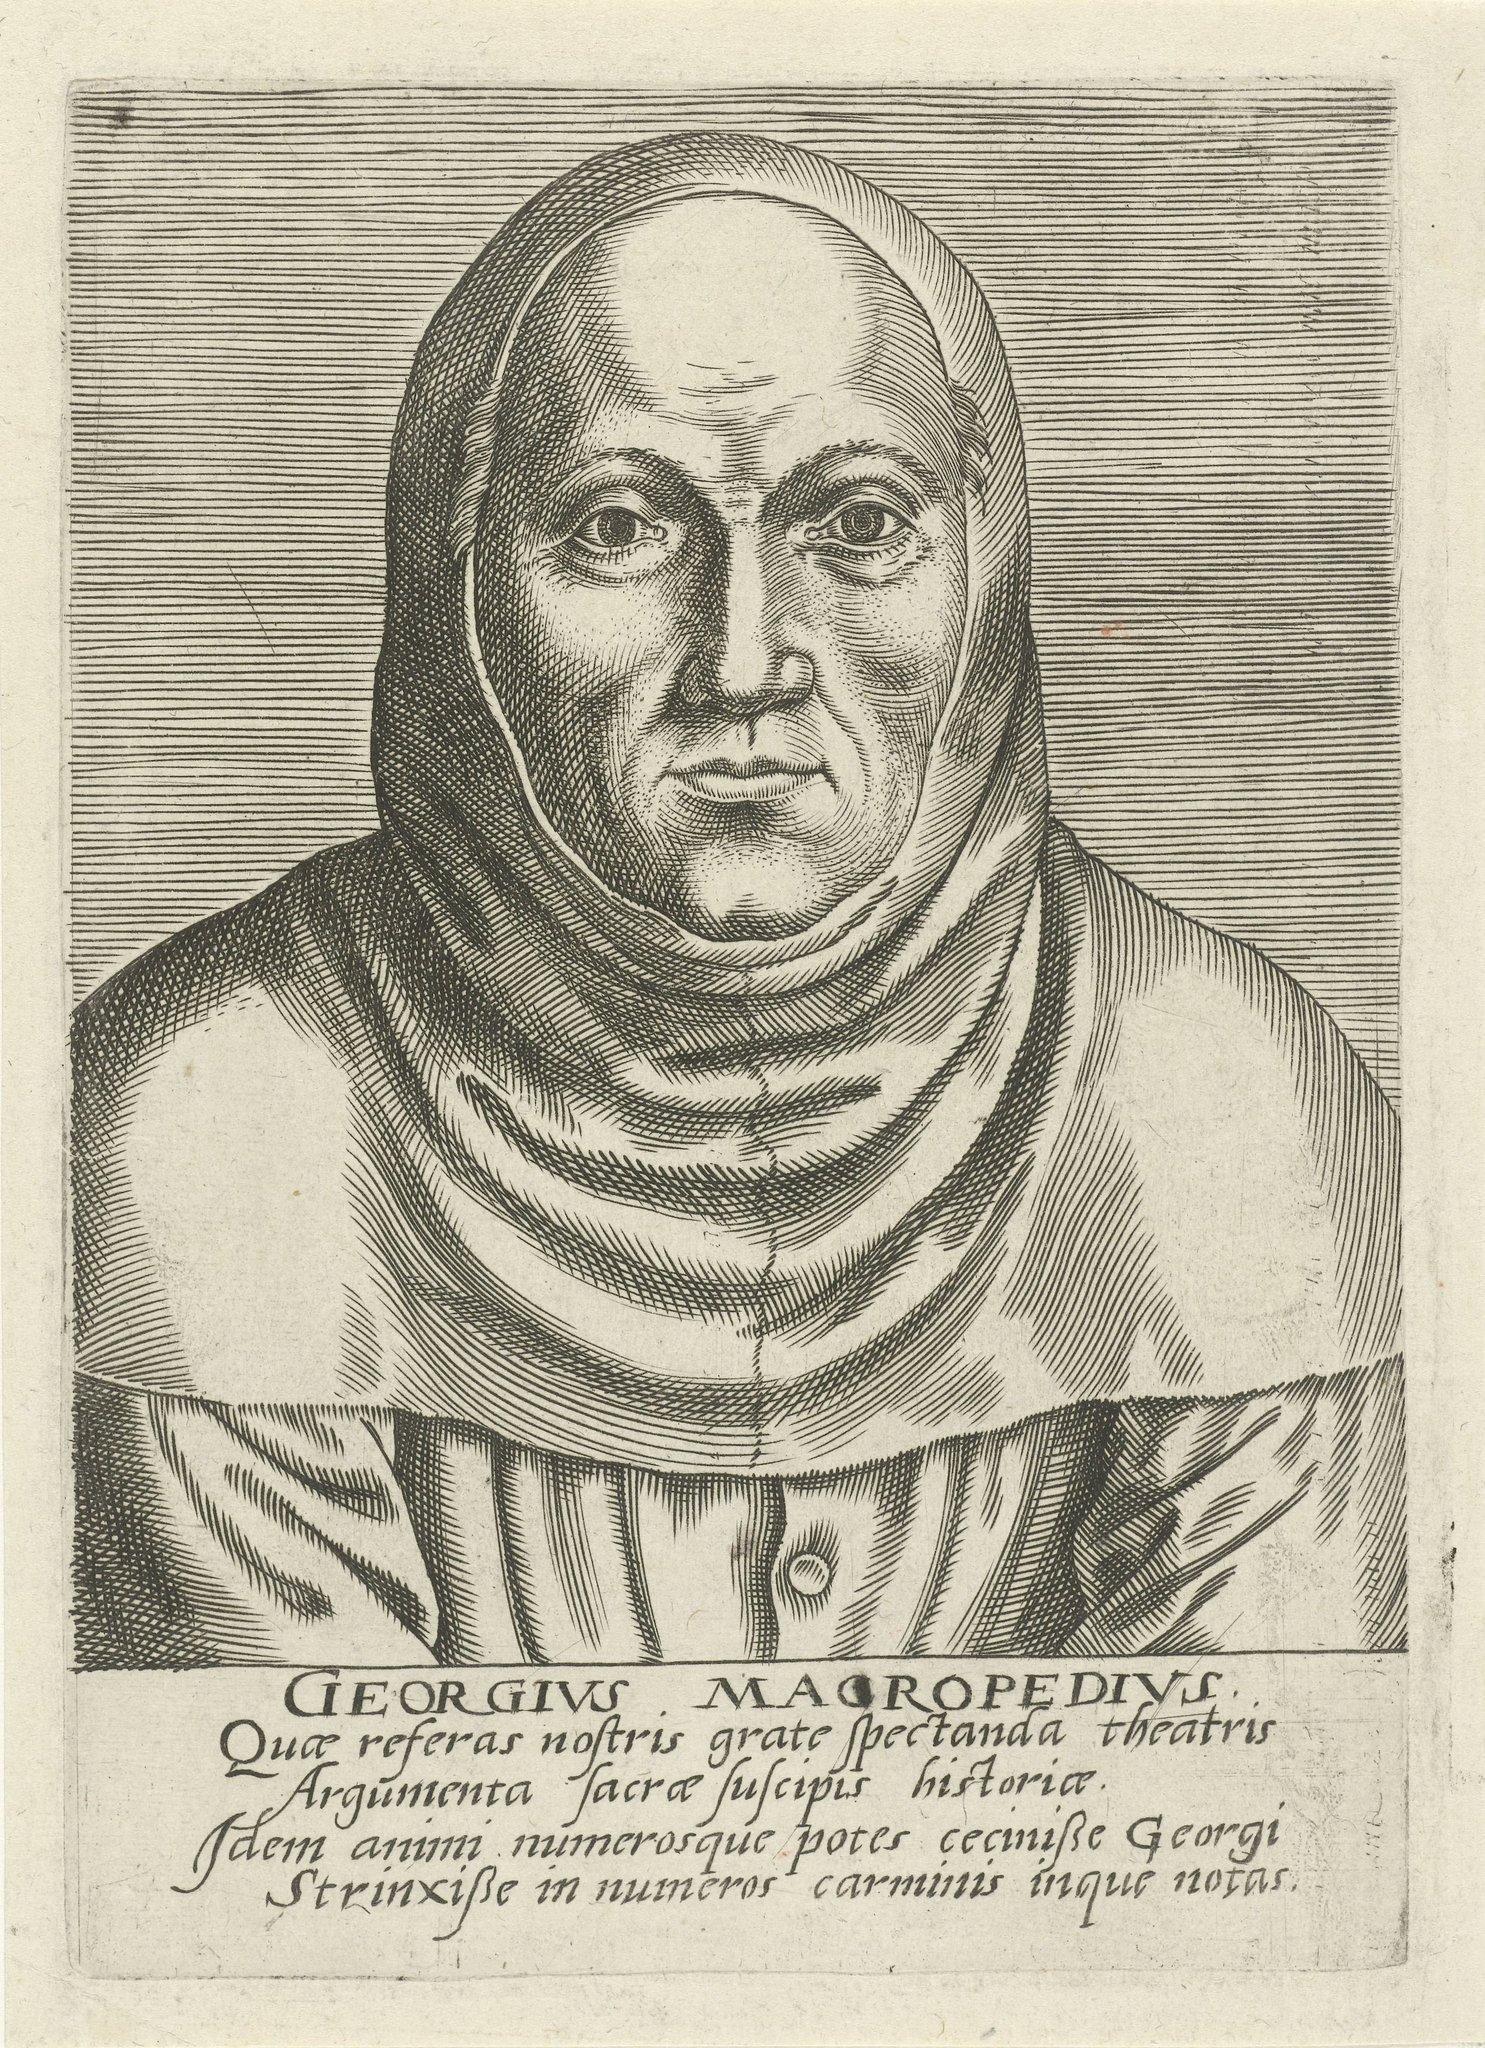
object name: print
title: Portret van Georgius Macropedius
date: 1567-1662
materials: paper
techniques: engraving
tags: gemert, den bosch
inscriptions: collector's mark: Lugt 2228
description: Portret van Georgius Macropedius, Nederlandse geleerde en humanist. De prent heeft een Latijns onderschrift.